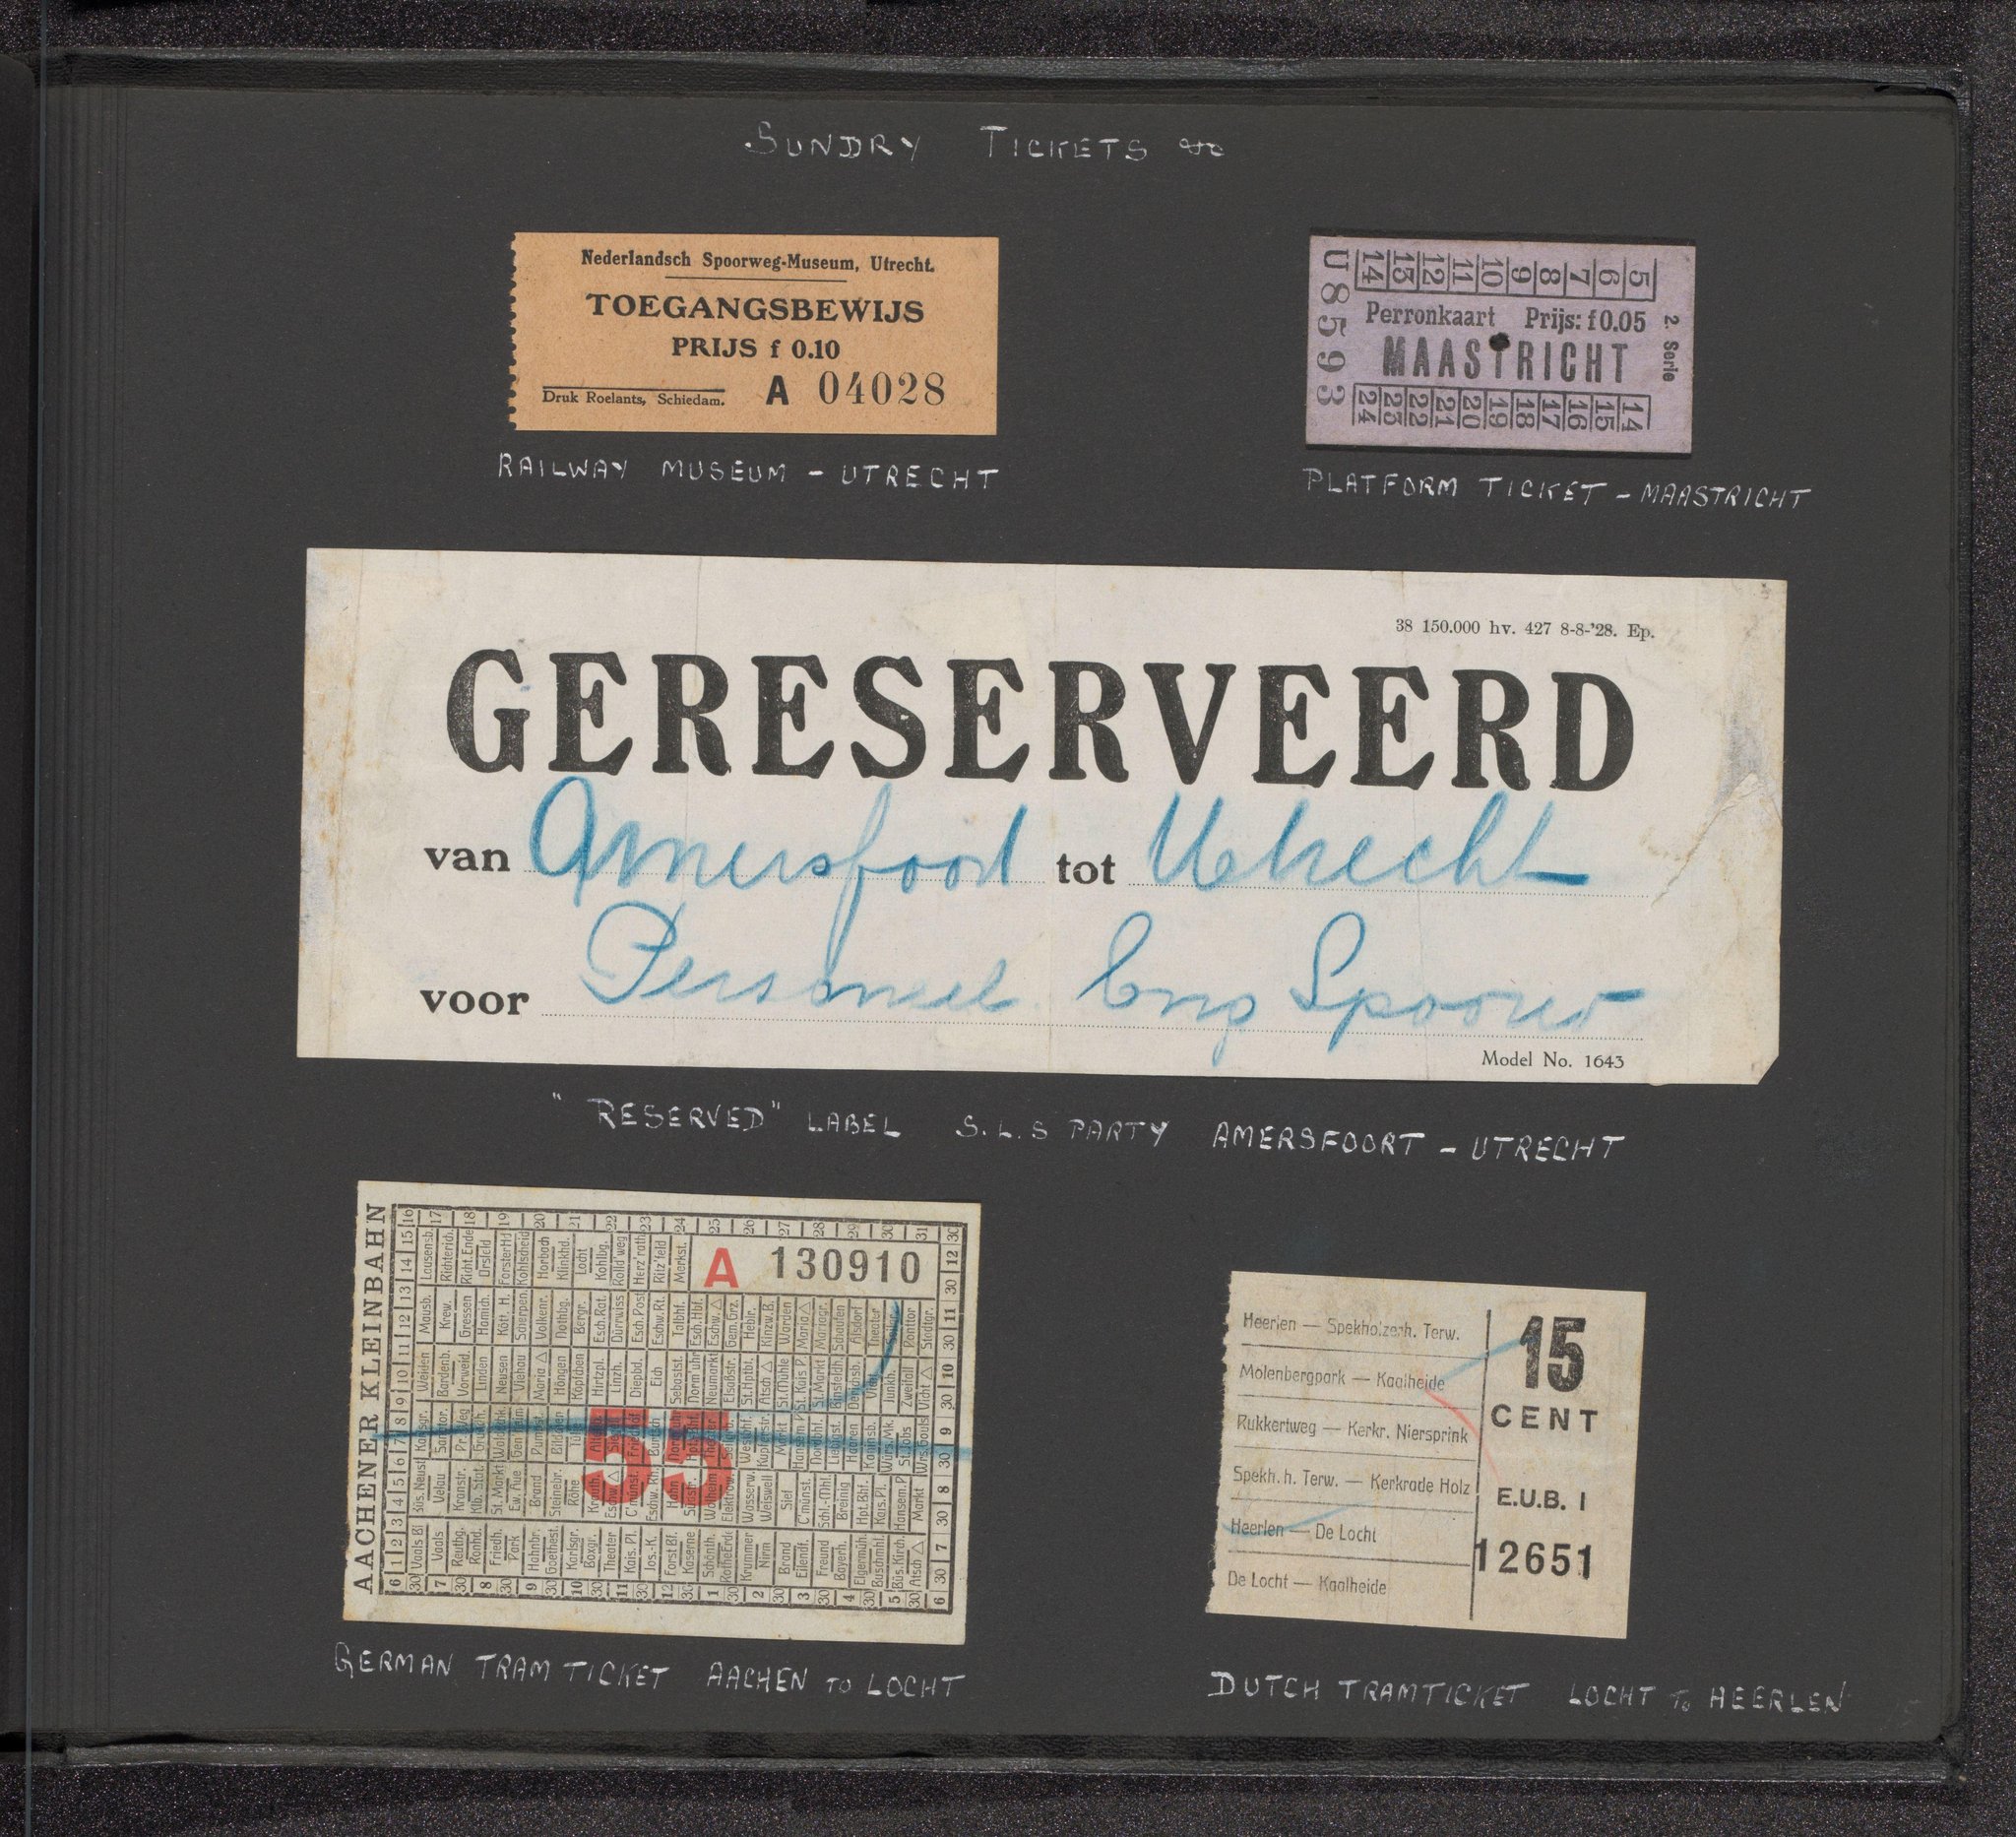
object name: photograph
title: Diverse kaartjes inzake railvervoer in Nederland en Duitsland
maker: Anonymous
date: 1930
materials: cardboard, ink, paper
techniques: printing, writing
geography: netherlands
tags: tramway, tram, railway, train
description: Albumblad met toegangsbewijs voor het Nederlandsch Spoorweg-Museum (linksboven), een perronkaartje (rechtsboven), een reserveringsopschrift (midden), een Duits tramkaartje voor het traject Aken-De Locht (linksonder) en een Nederlands tramkaartje voor het traject De Locht-Heerlen. Onderdeel van Fotografische reisverslag van het bezoek van de Stephenson Locomotive Society aan Nederland.